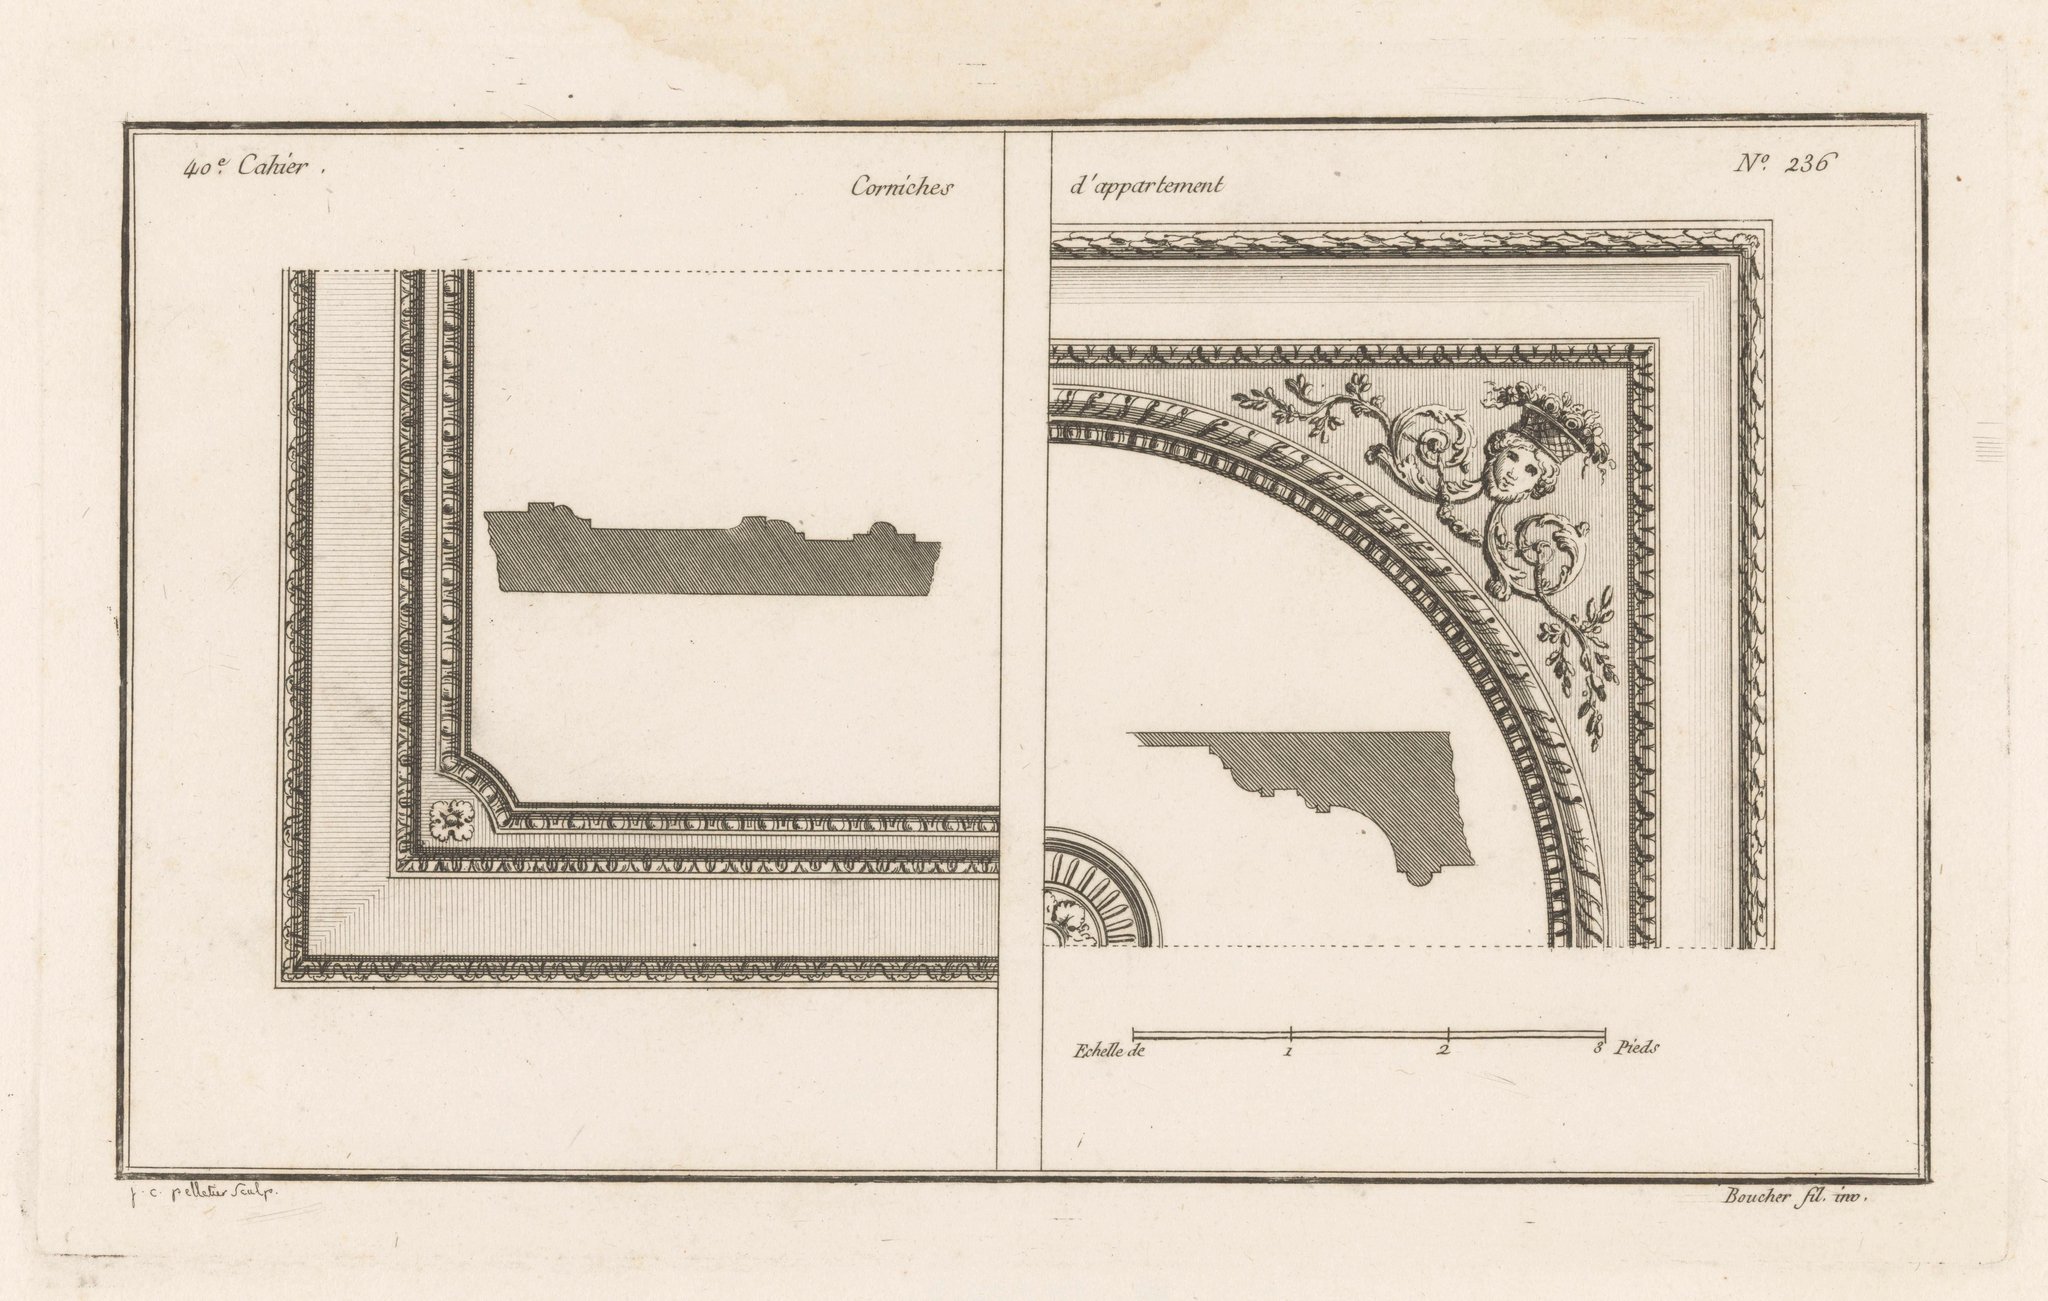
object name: ornament print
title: Plafonds met gezicht en vlechtwerk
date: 1772-1779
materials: paper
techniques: engraving, etching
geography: paris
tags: interlace ~ ornament, mask, mascaron ~ ornament, (decorated) ceiling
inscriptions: collector's mark: Lugt 2228, collector's mark: Lugt 2760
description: Profielen en details van twee geornamenteerde plafonds. Rechts met een gezicht met mand op het hoofd omgeven door vlechtwerk, in het midden een rond element. Prentnummer 236.